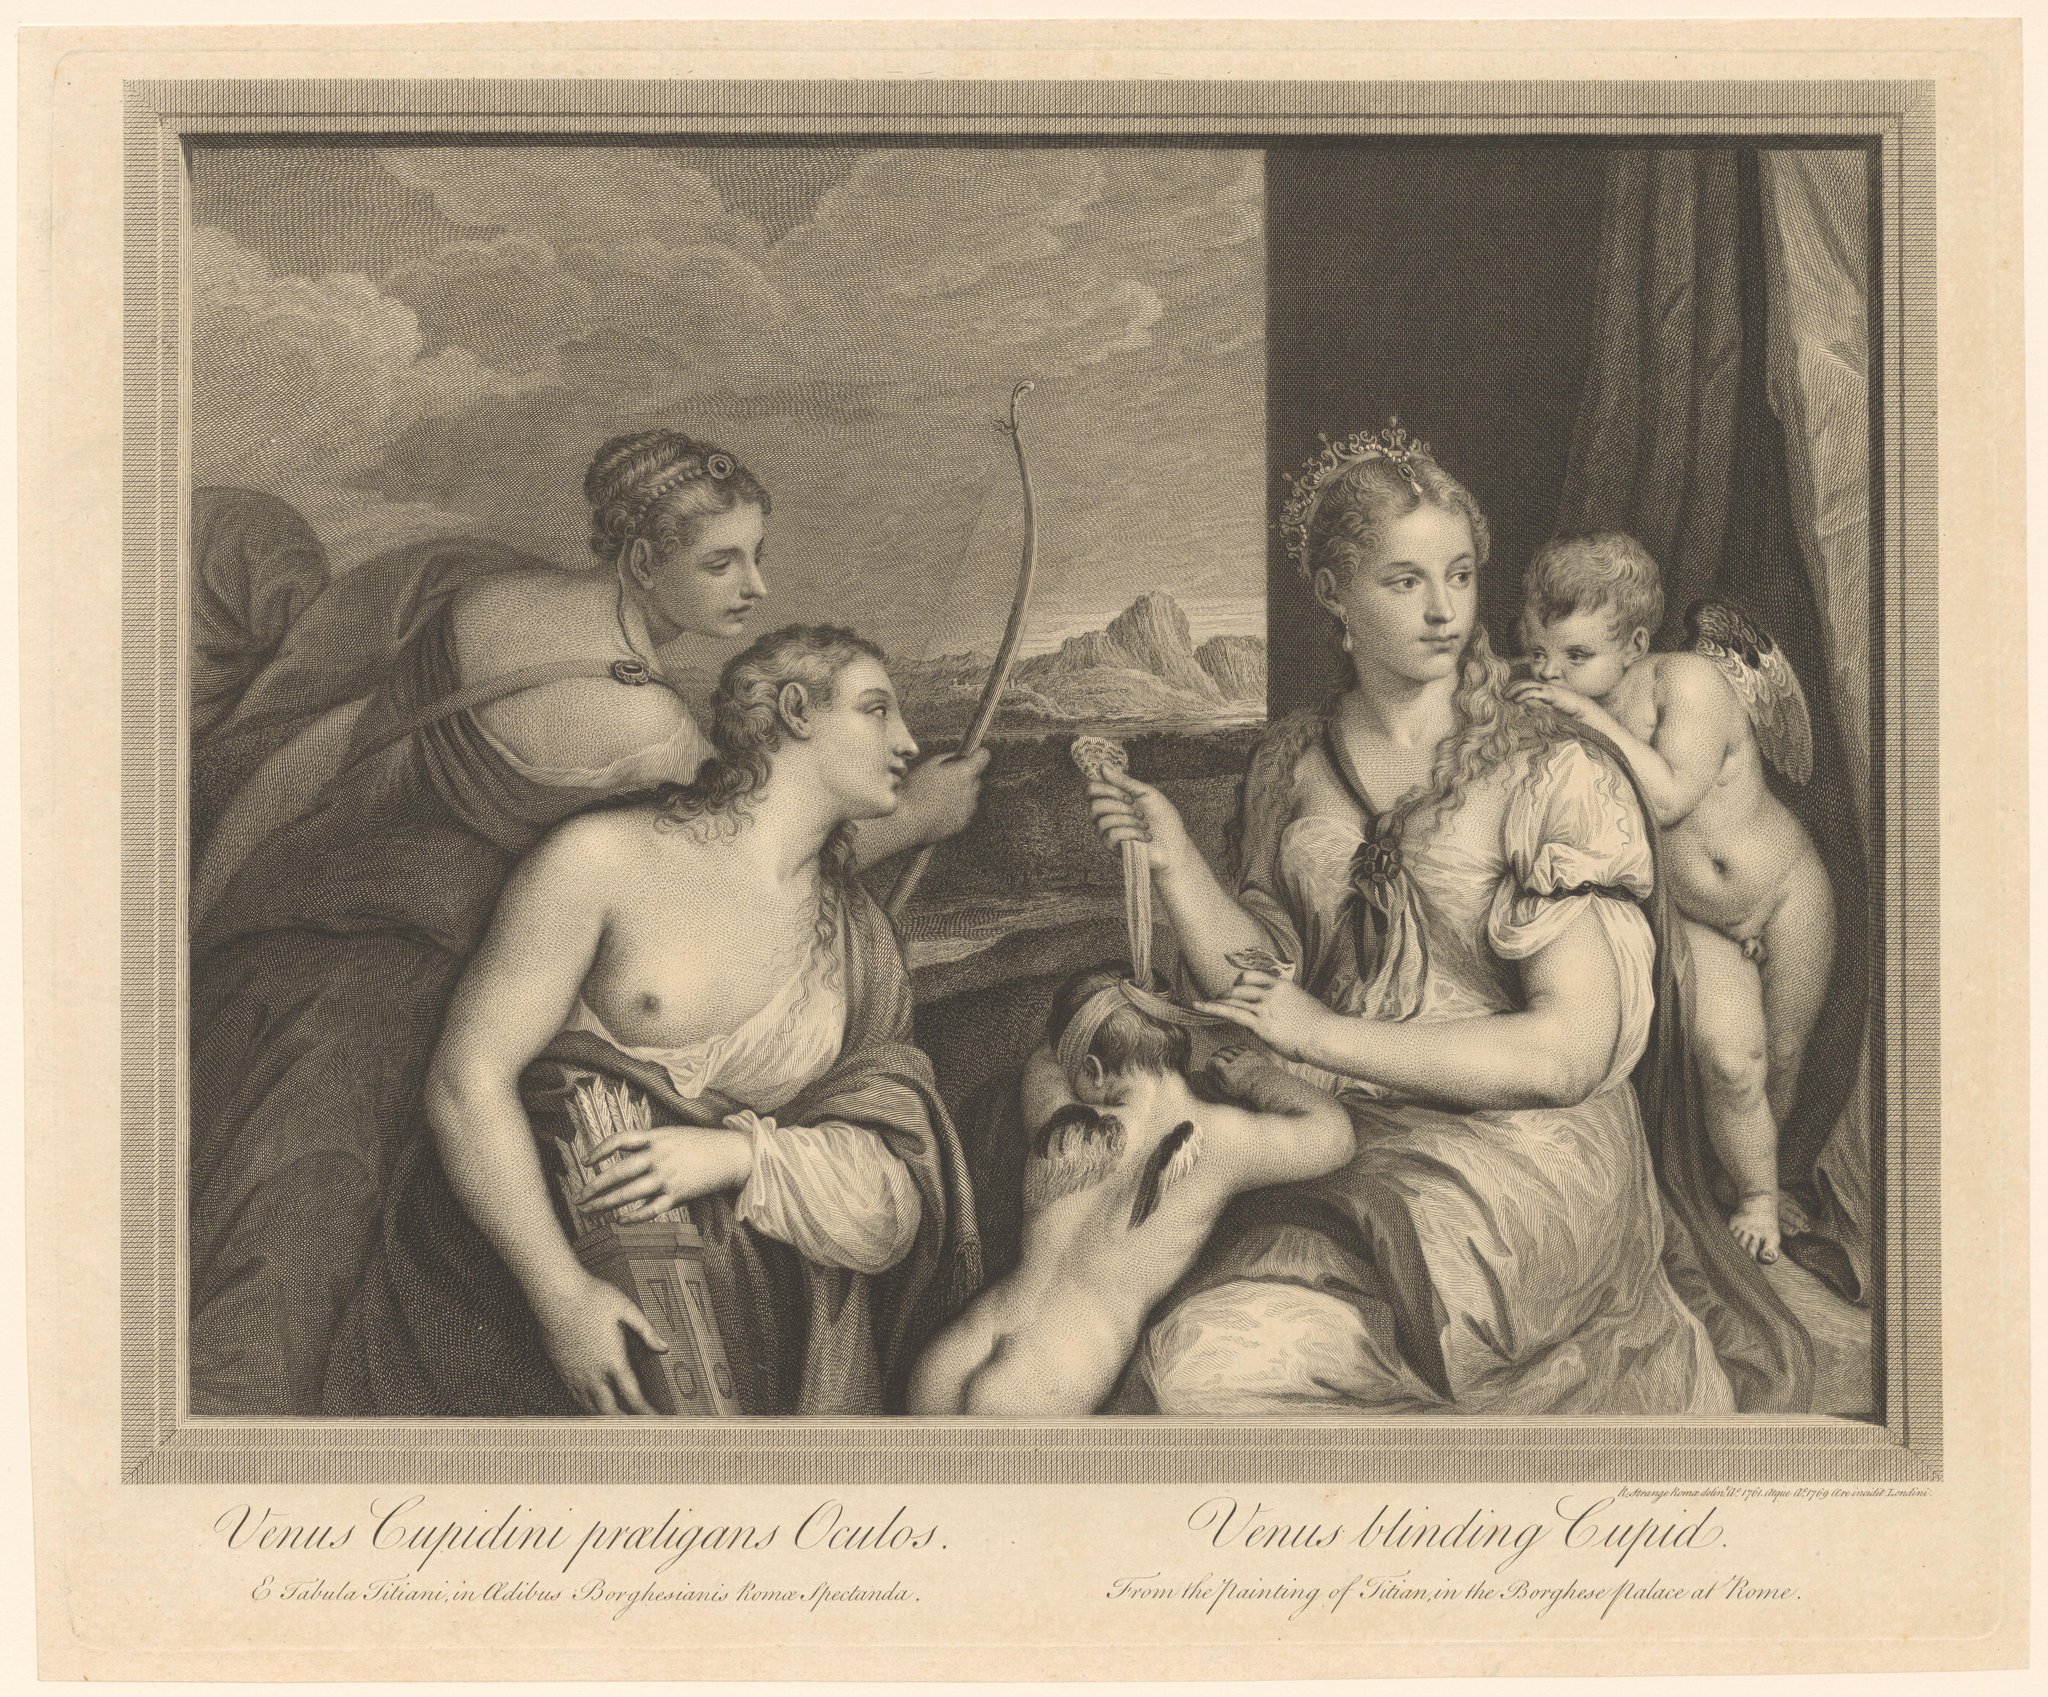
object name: print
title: Venus Cupidini praeligans Oculos / Venus blinding Cupid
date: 1769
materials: paper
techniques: engraving, etching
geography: rome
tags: attributes of cupid: blindfold, venus and cupid (cupid not being mere attribute)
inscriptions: collector's mark: Lugt 2228